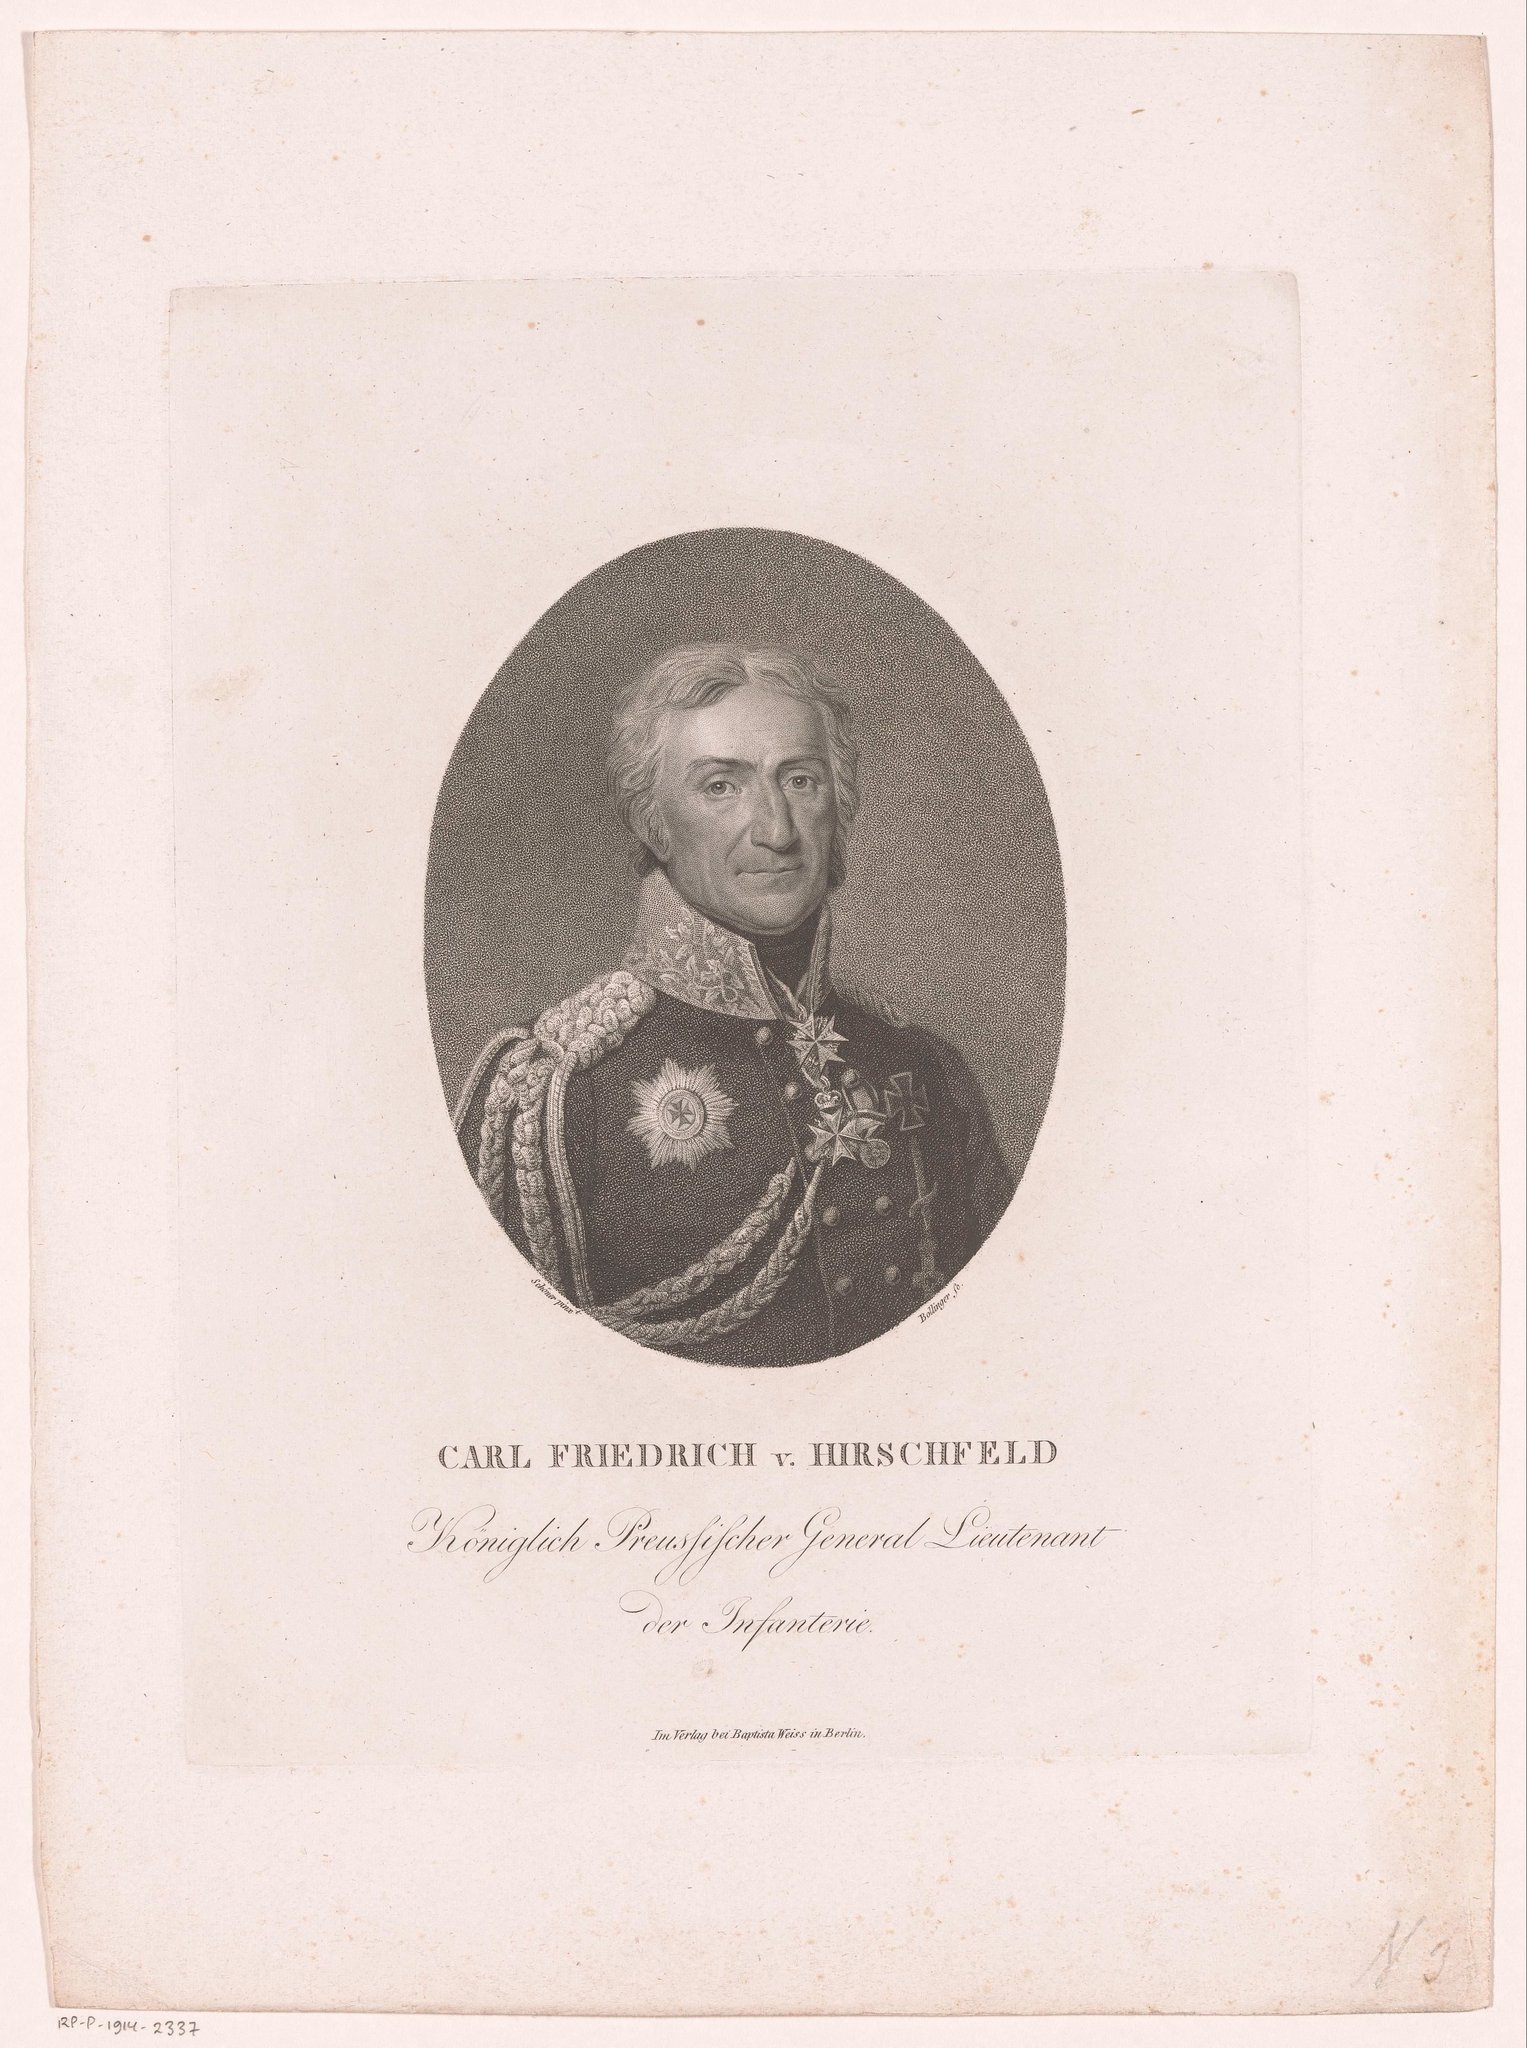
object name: print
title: Portret van Carl Friedrich von Hirschfeld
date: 1800-1825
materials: paper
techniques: stippling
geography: berlin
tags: knighthood order, historical persons, (military) uniforms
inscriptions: collector's mark: Lugt 2228